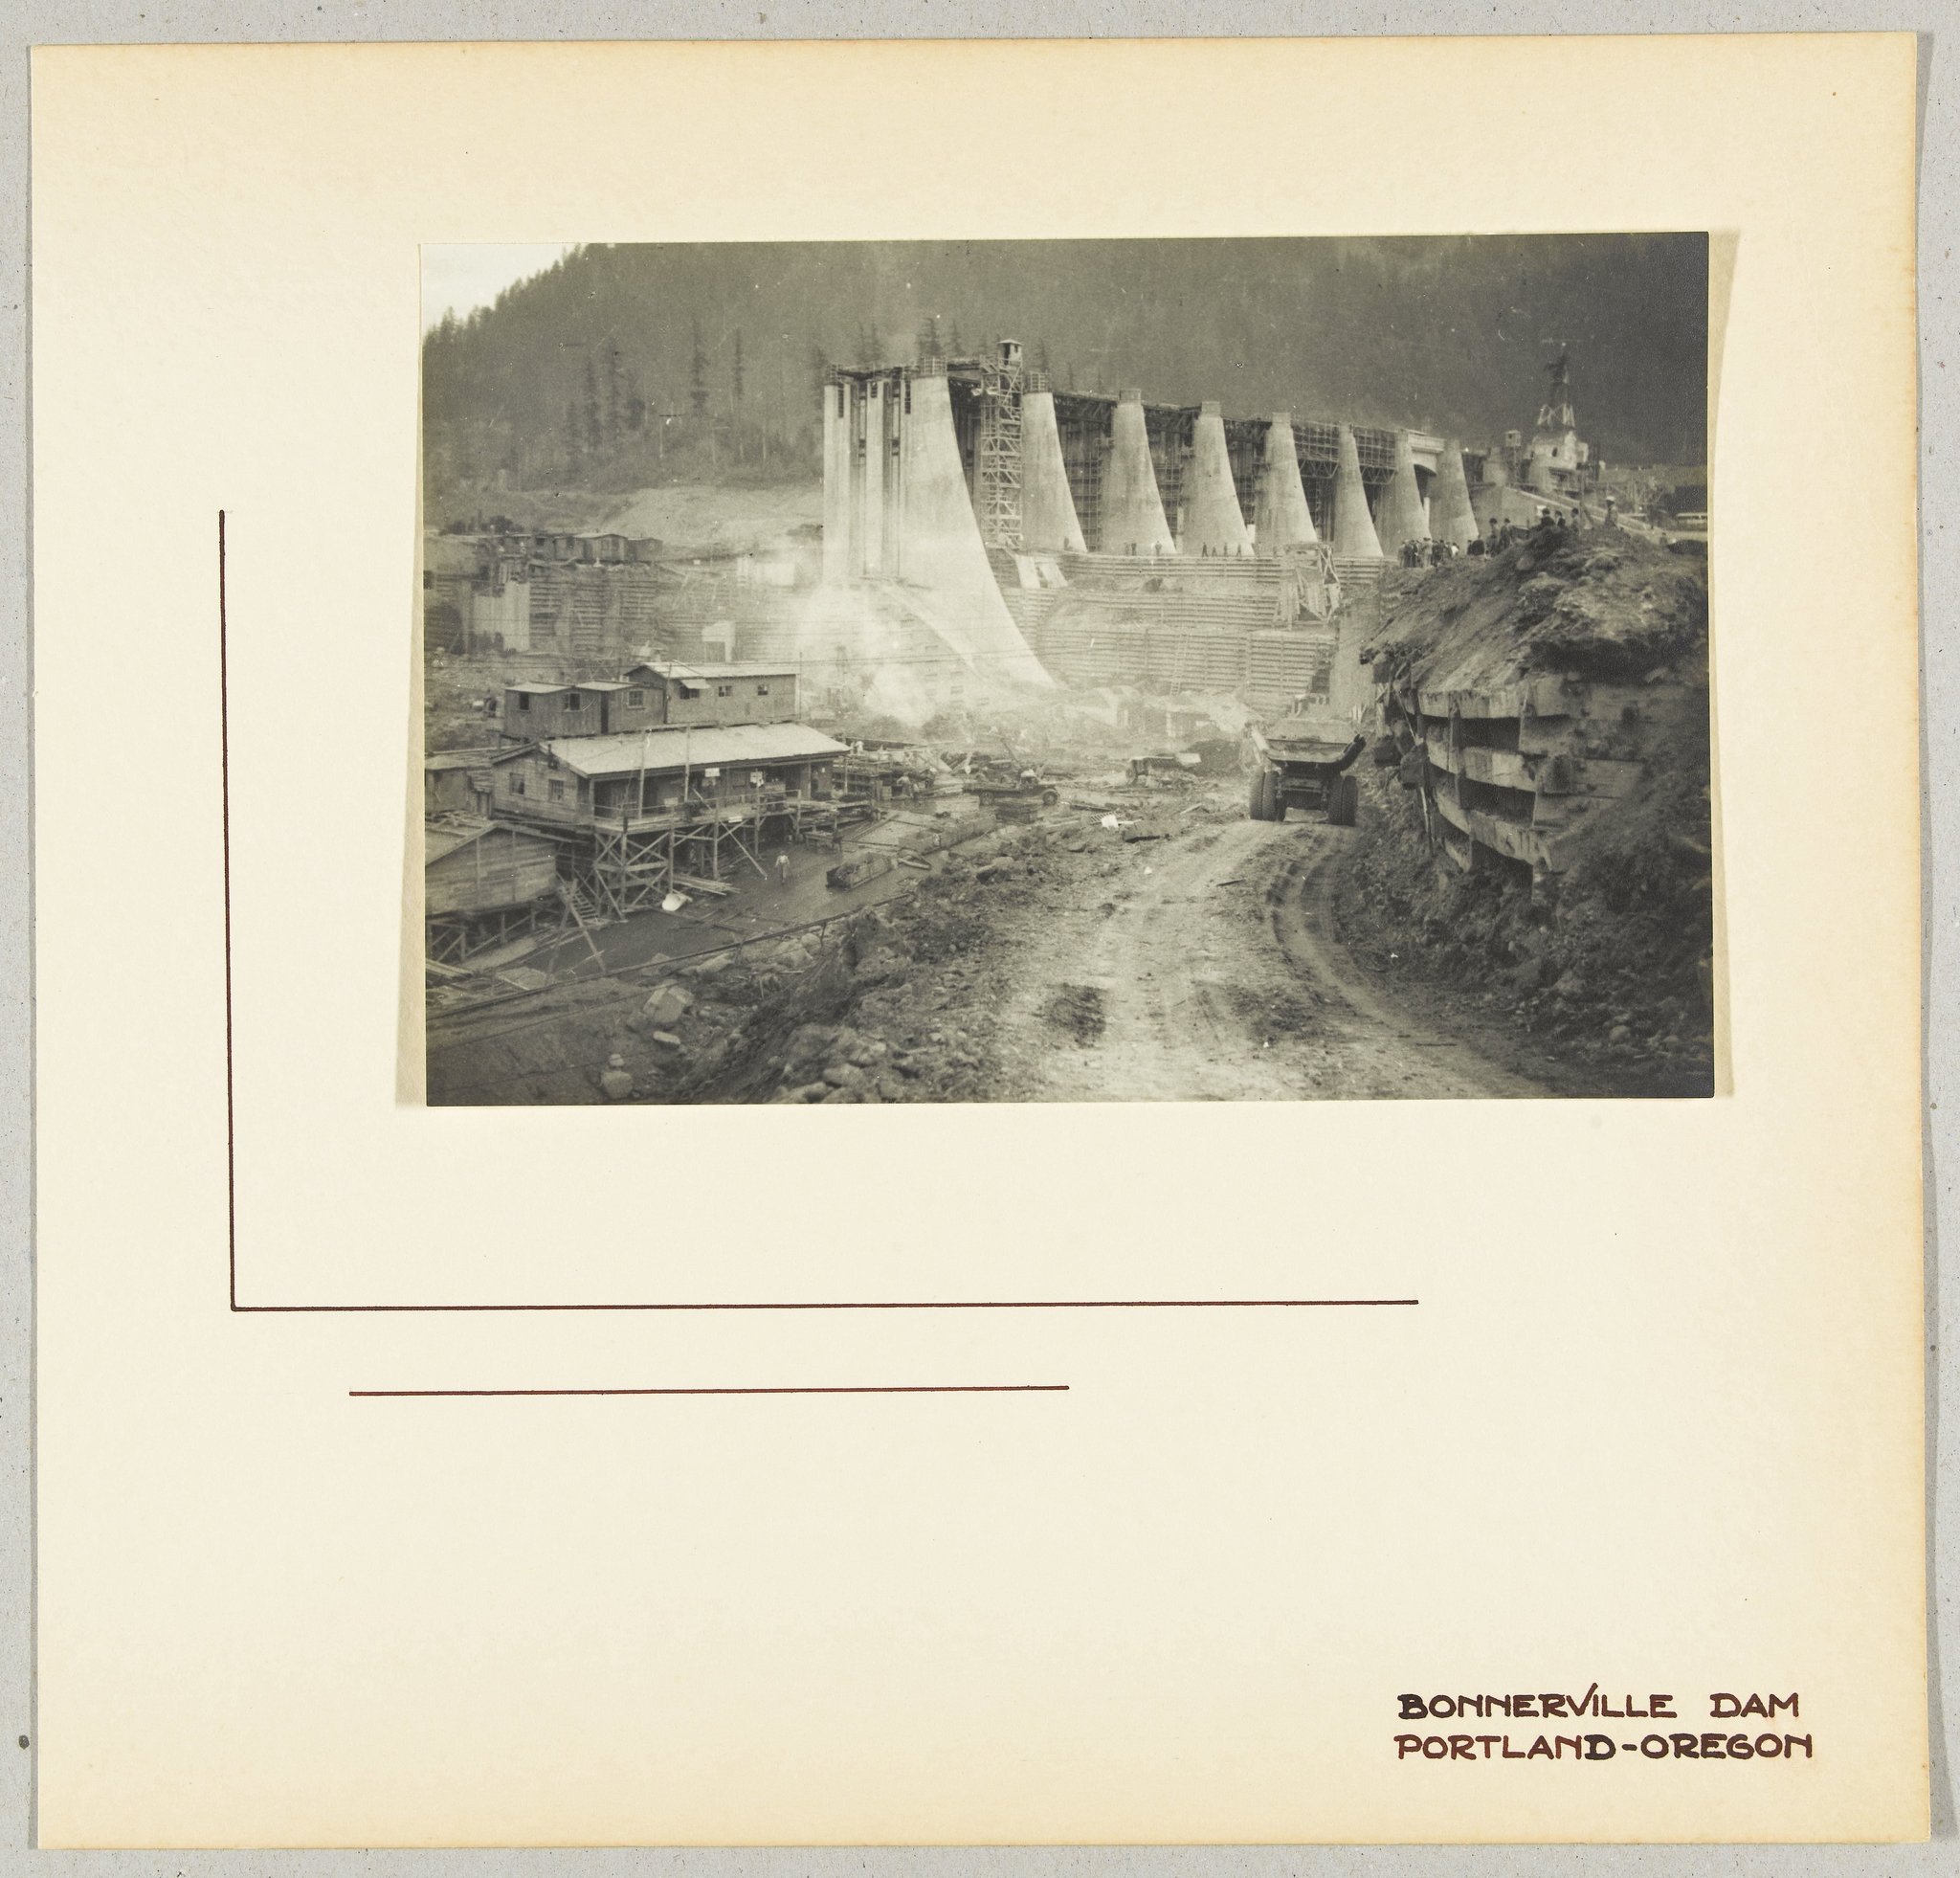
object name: photograph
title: Bonnerville Dam, Portland, Oregon, Verenigde Staten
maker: wouter cool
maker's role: engineer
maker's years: 1877-1947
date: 1936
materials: cardboard, paper, photographic support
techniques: gelatin silver print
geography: united states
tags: dam (in canal)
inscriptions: title: ‘BONNERVILLE DAM / PORTLAND-OREGON’